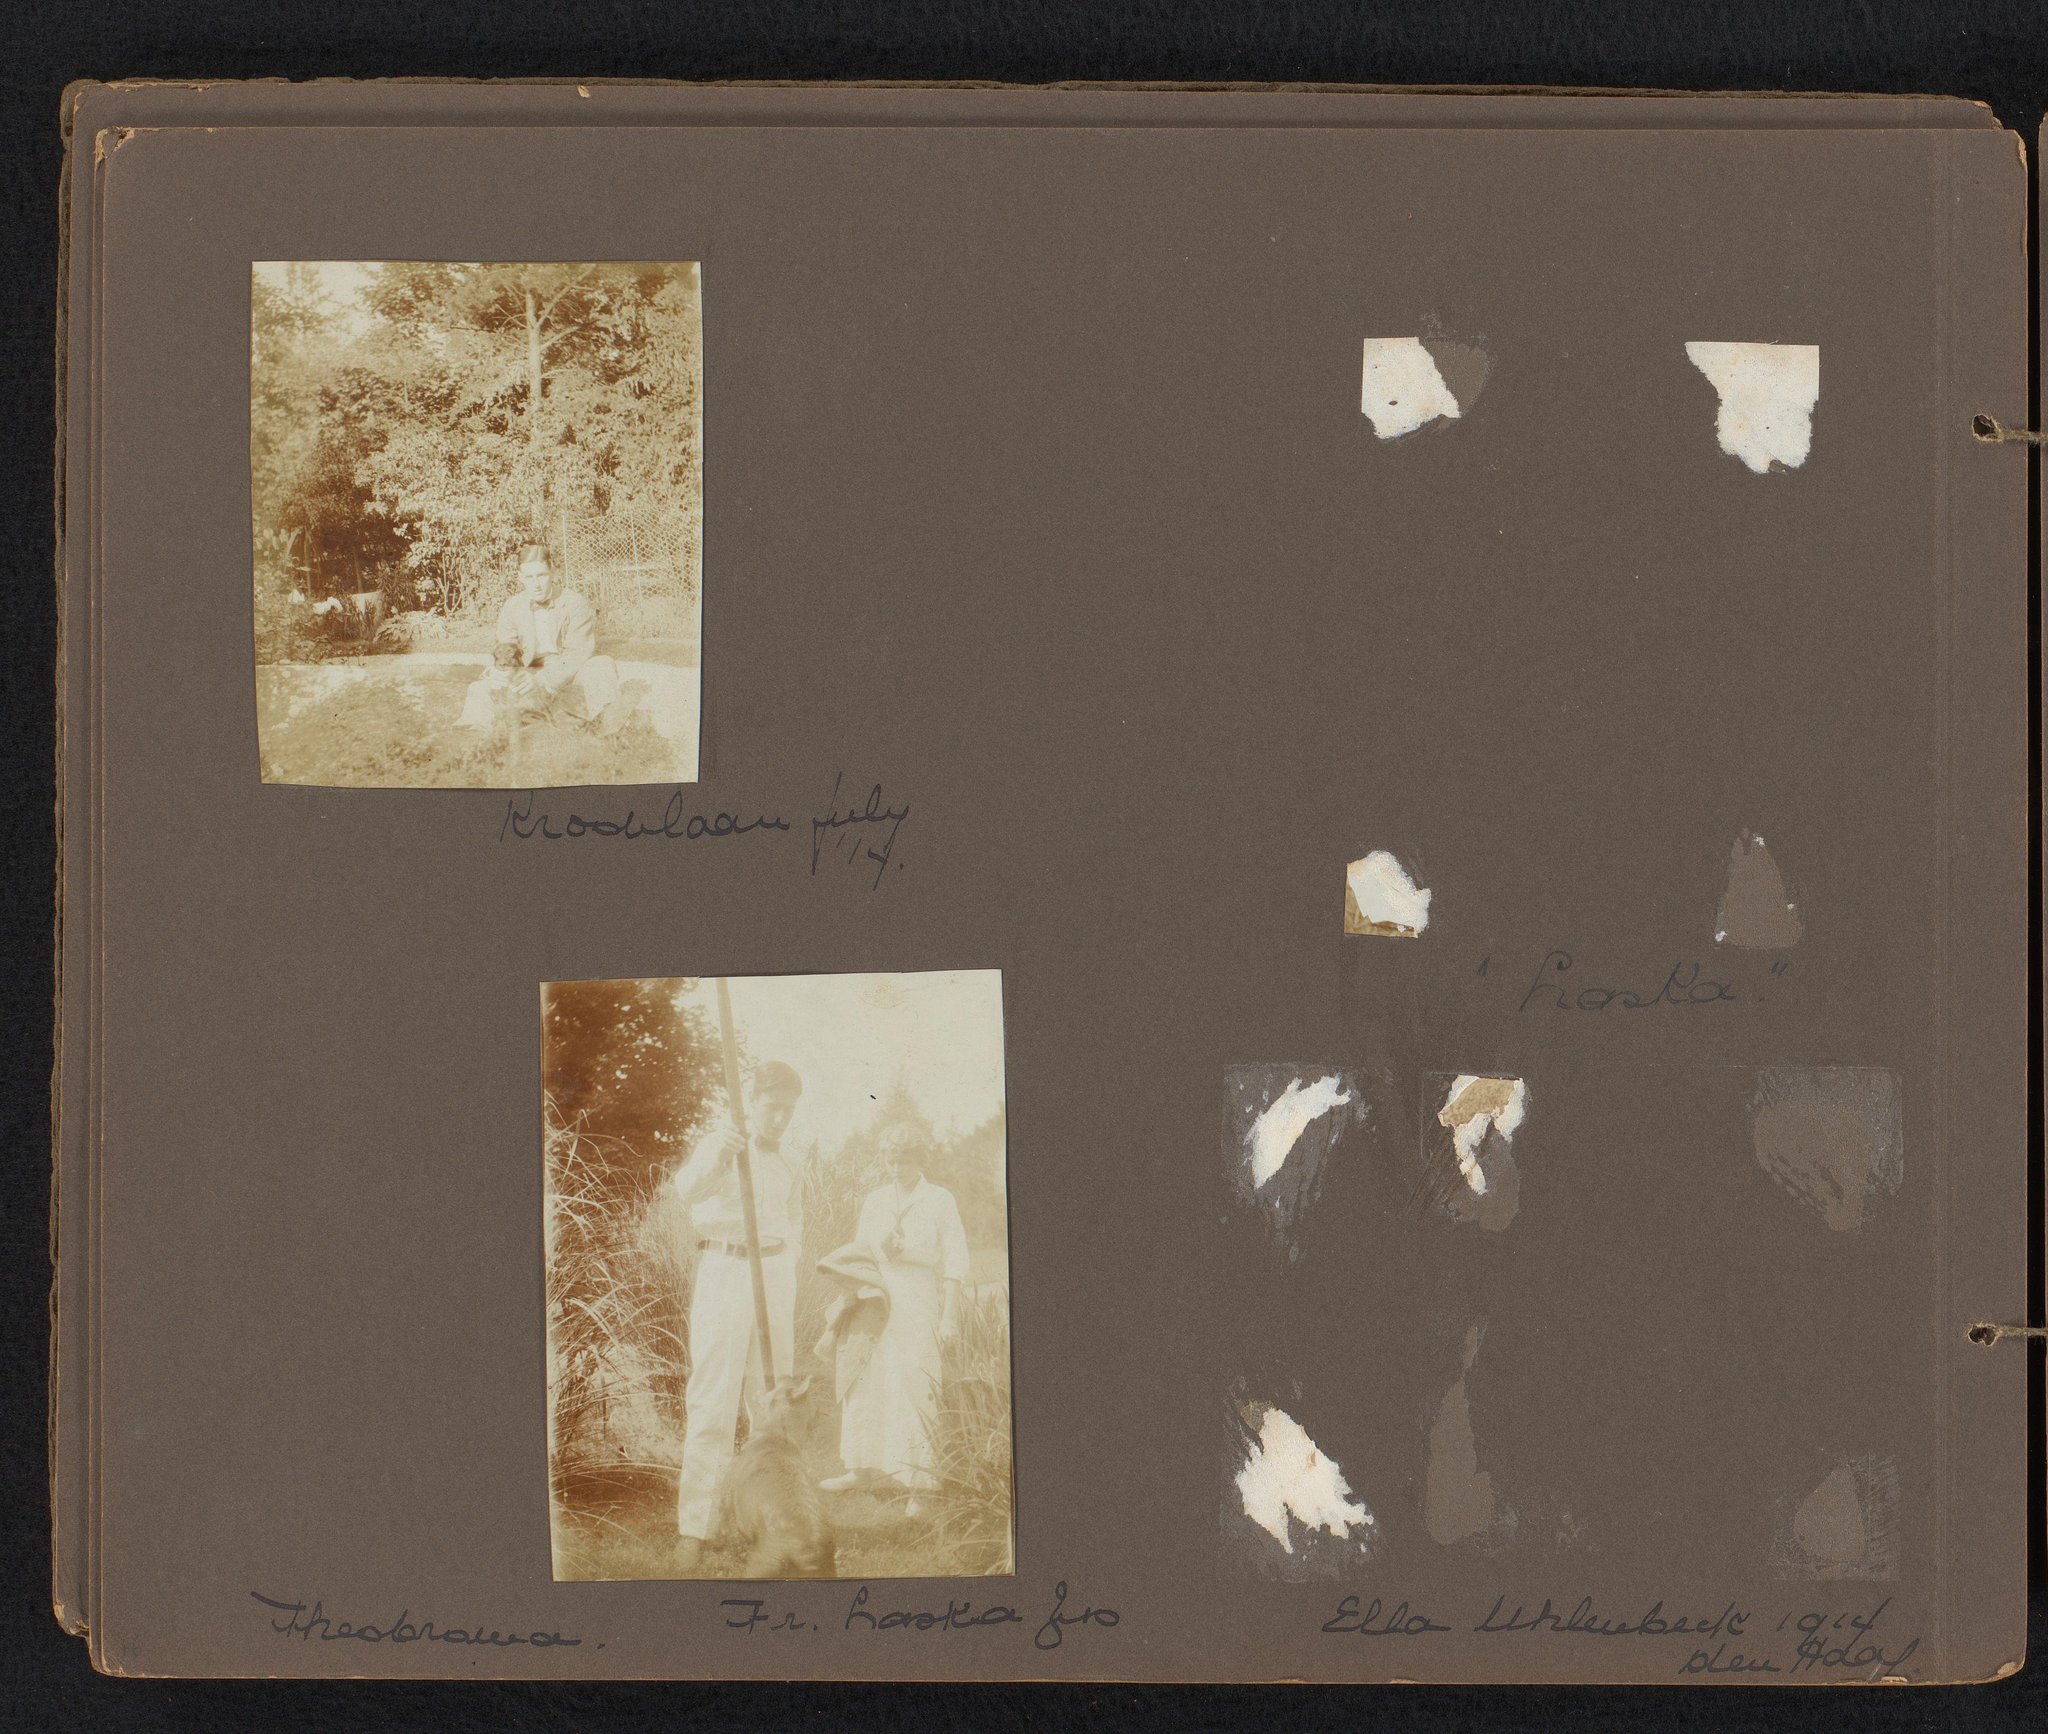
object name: photograph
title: Twee foto's van vrienden van Loentje Onnen in een tuin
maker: carolina frederika onnen (lien/loen)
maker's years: 1896-1983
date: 1907-1914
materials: paper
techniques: gelatin silver print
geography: hilversum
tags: garden, dog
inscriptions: inscription: ‘Kroonlaan July/ '14’, inscription: ‘"Laska"’, inscription: ‘Ella Uhlenbeck 1914/ den Haag.’, inscription: ‘Theobroma. Fr. Laska Zus’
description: Deze foto's maken deel uit van een album.